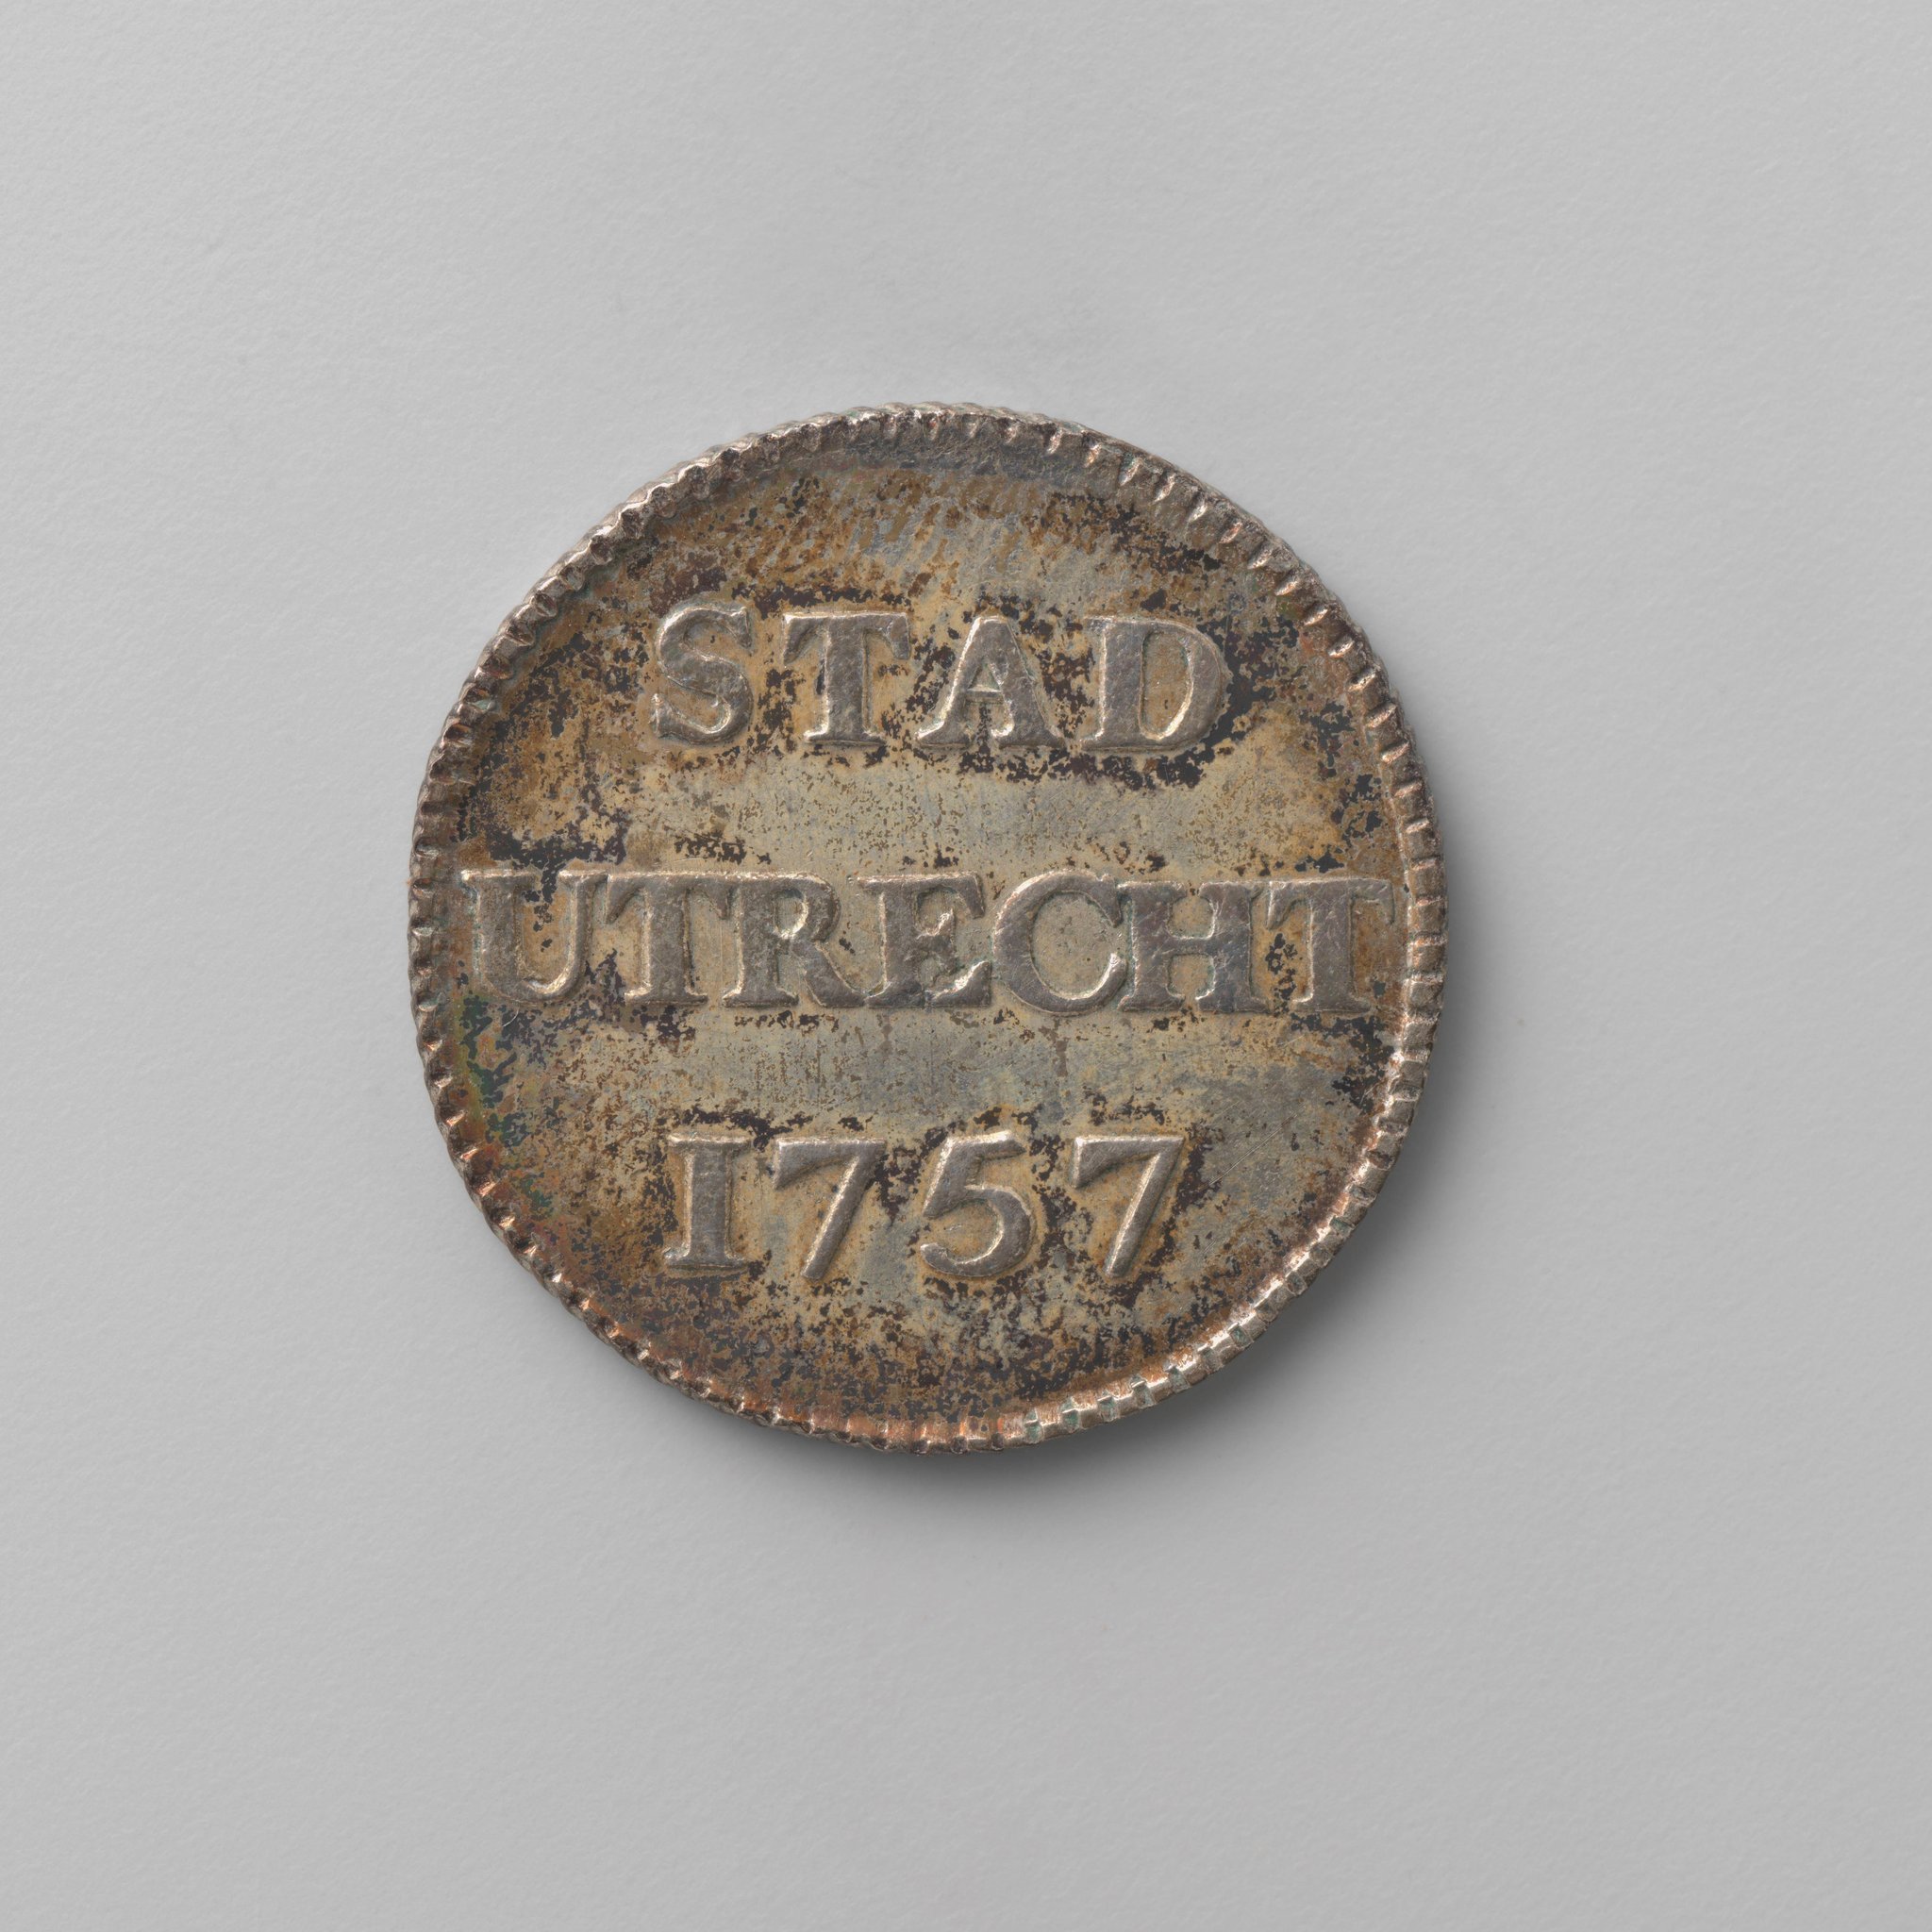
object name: coin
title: Duit van de stad Utrecht, 1757. Afslag in zilver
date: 1757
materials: silver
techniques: striking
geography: utrecht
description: Zilveren munt. Voorzijde: gekroond stedelijk wapenschild, gehouden door twee leeuwen met in afsnede dunne lijn, waaronder een versierde accolade met een grote schelp. Keerzijde: opschrift in twee regels, waaronder jaartal. Jaartal met Romeinse I. Afslag in zilver. Kabelrand.